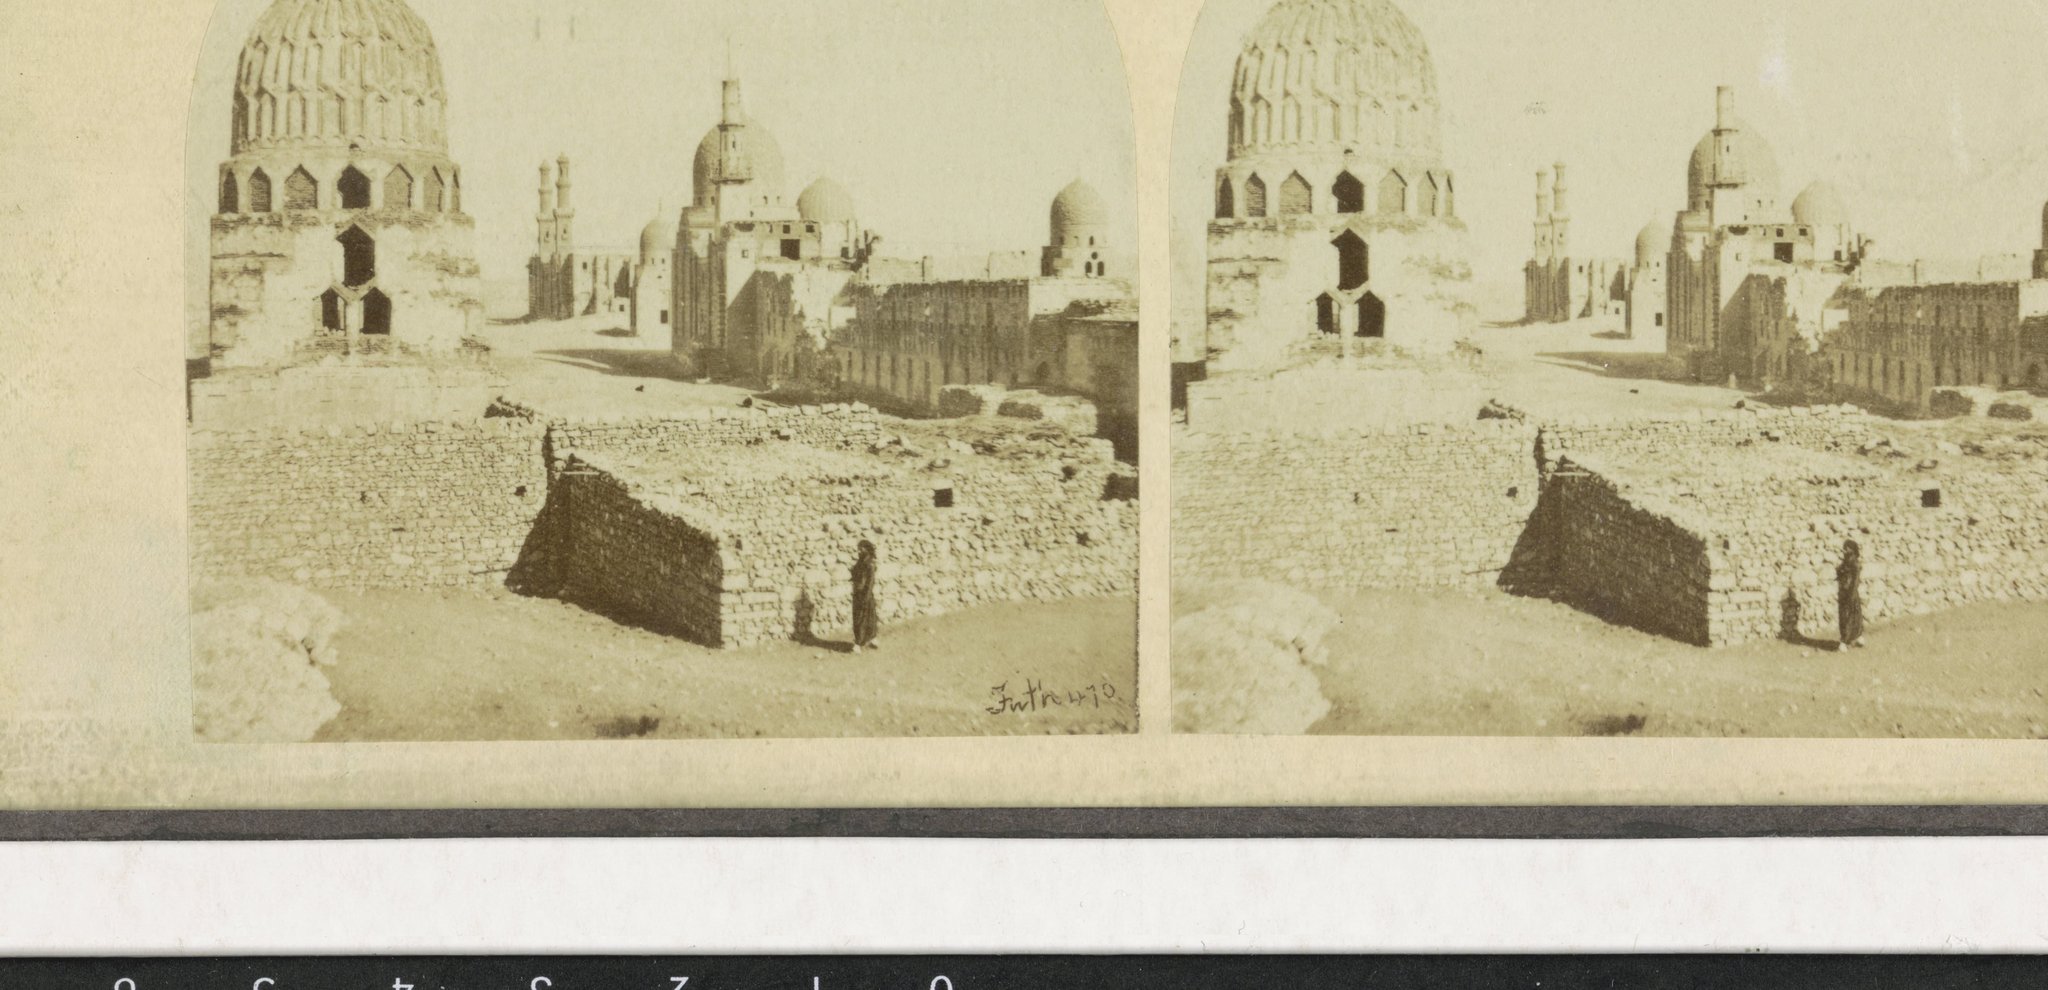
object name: photograph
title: Graven van de kaliefen, Caïro, Egypte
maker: francis frith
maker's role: publisher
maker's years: 1822-1898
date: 1856-1860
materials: cardboard, glass, paper, photographic support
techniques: albumen print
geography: great britain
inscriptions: label: ‘No. 4 / Egypte. / Vue des tombeaux des rois Mameloukes, / au Caire, No. 2’, inscription: ‘Frith 470’